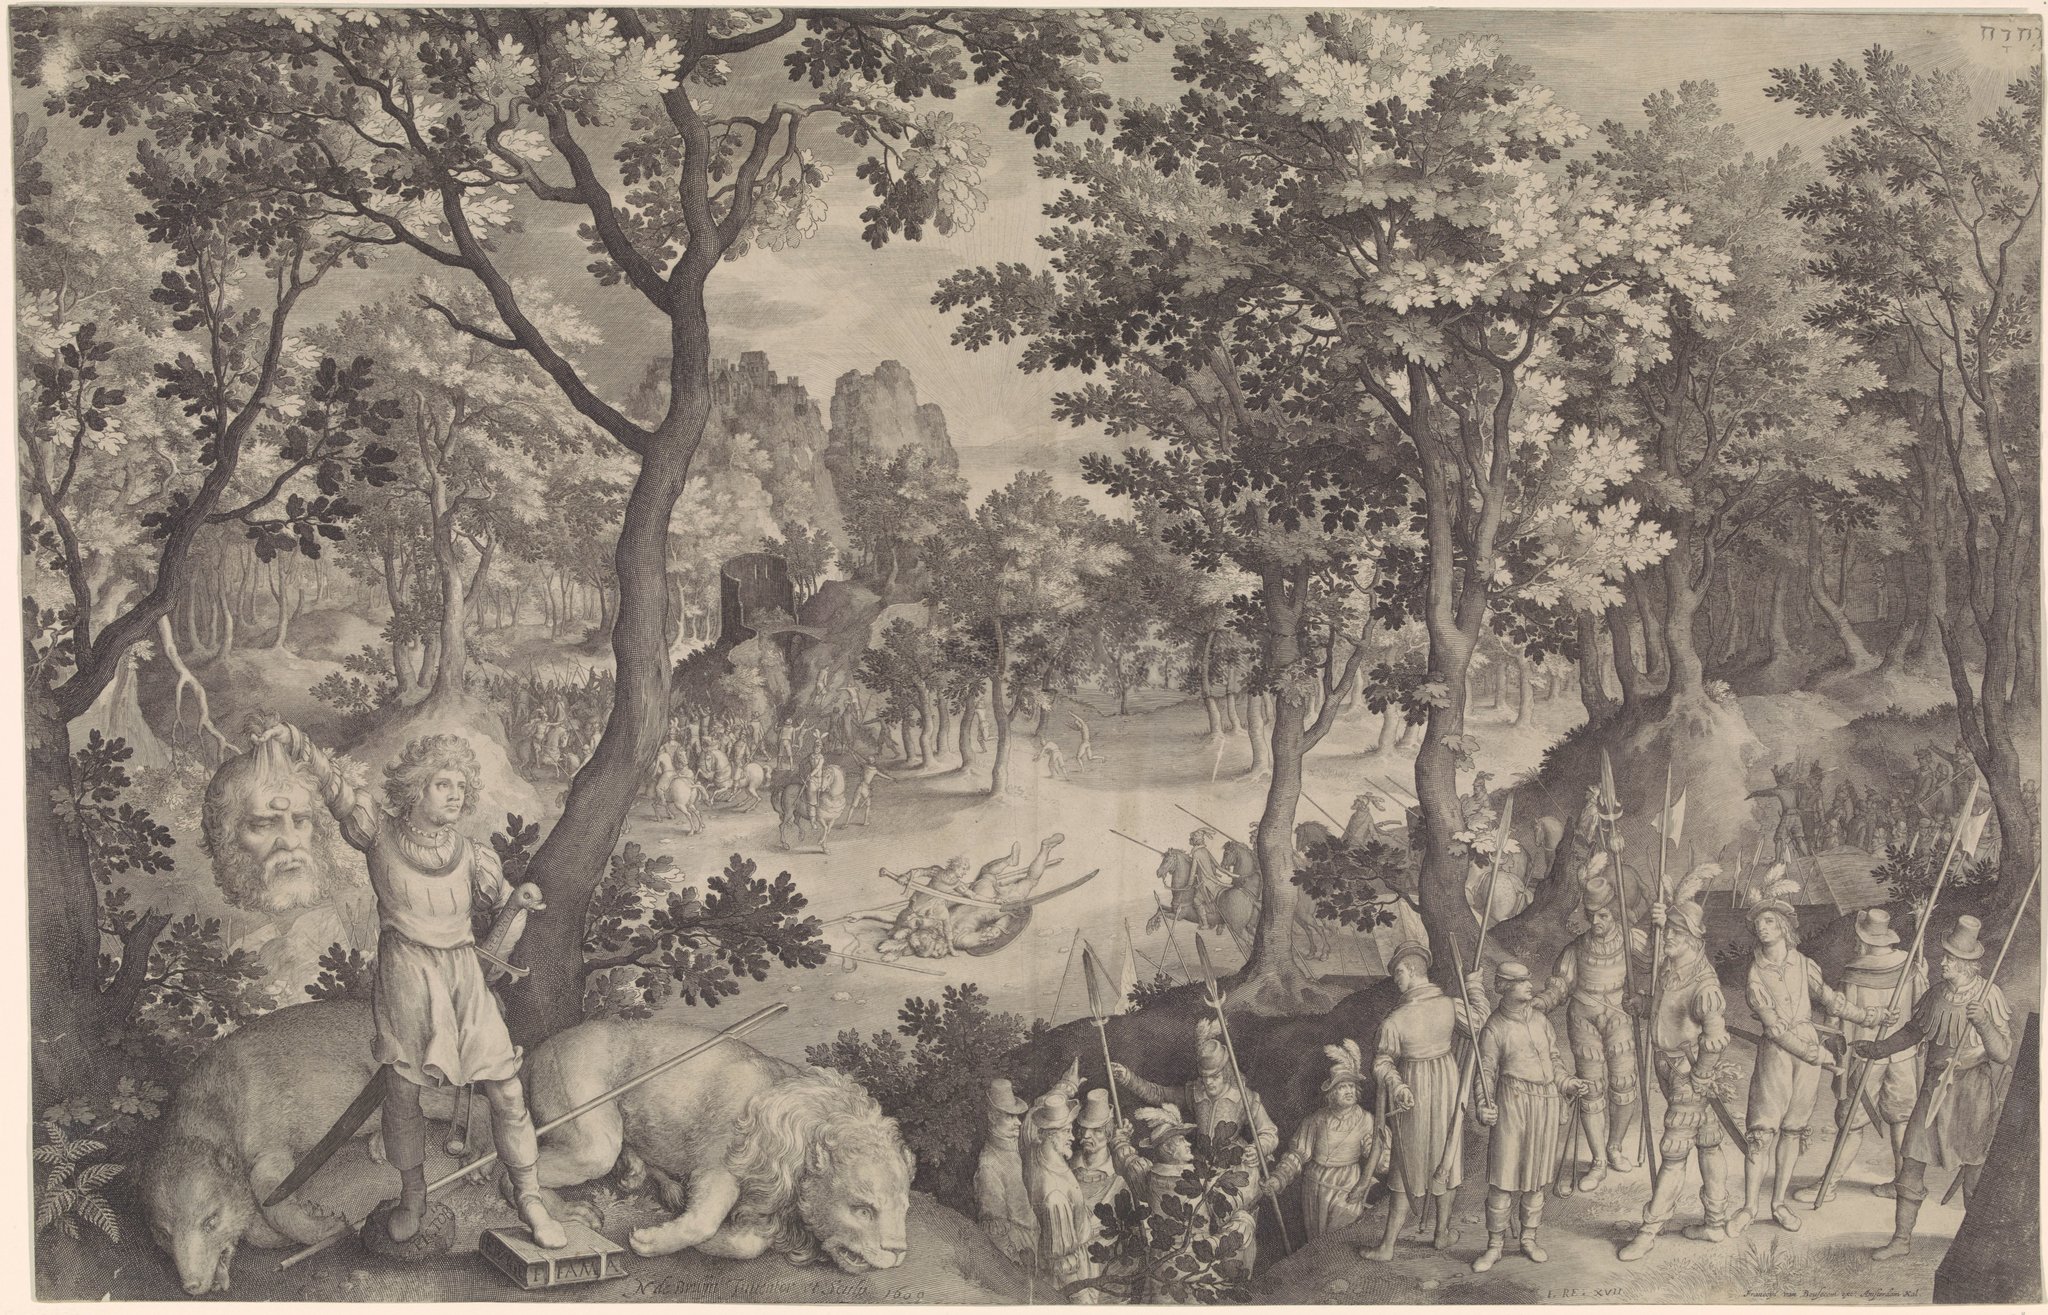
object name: print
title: David en Goliat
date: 1609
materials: paper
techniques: engraving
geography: antwerp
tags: david kills a lion and a bear (or tells saul about it), david with goliath's head, david beheads goliath with a sword, the armies of the israelites and the philistines stand facing each other in the valley of elah ~ story of david and goliath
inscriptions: collector's mark: Lugt 2228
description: In het midden de strijd tussen Filistijnen en Israelieten. David staat op het punt Goliat te onthoofden. Op de voorgrond David met het hoofd van Goliat. Achter hem een dode beer en een dode leeuw.